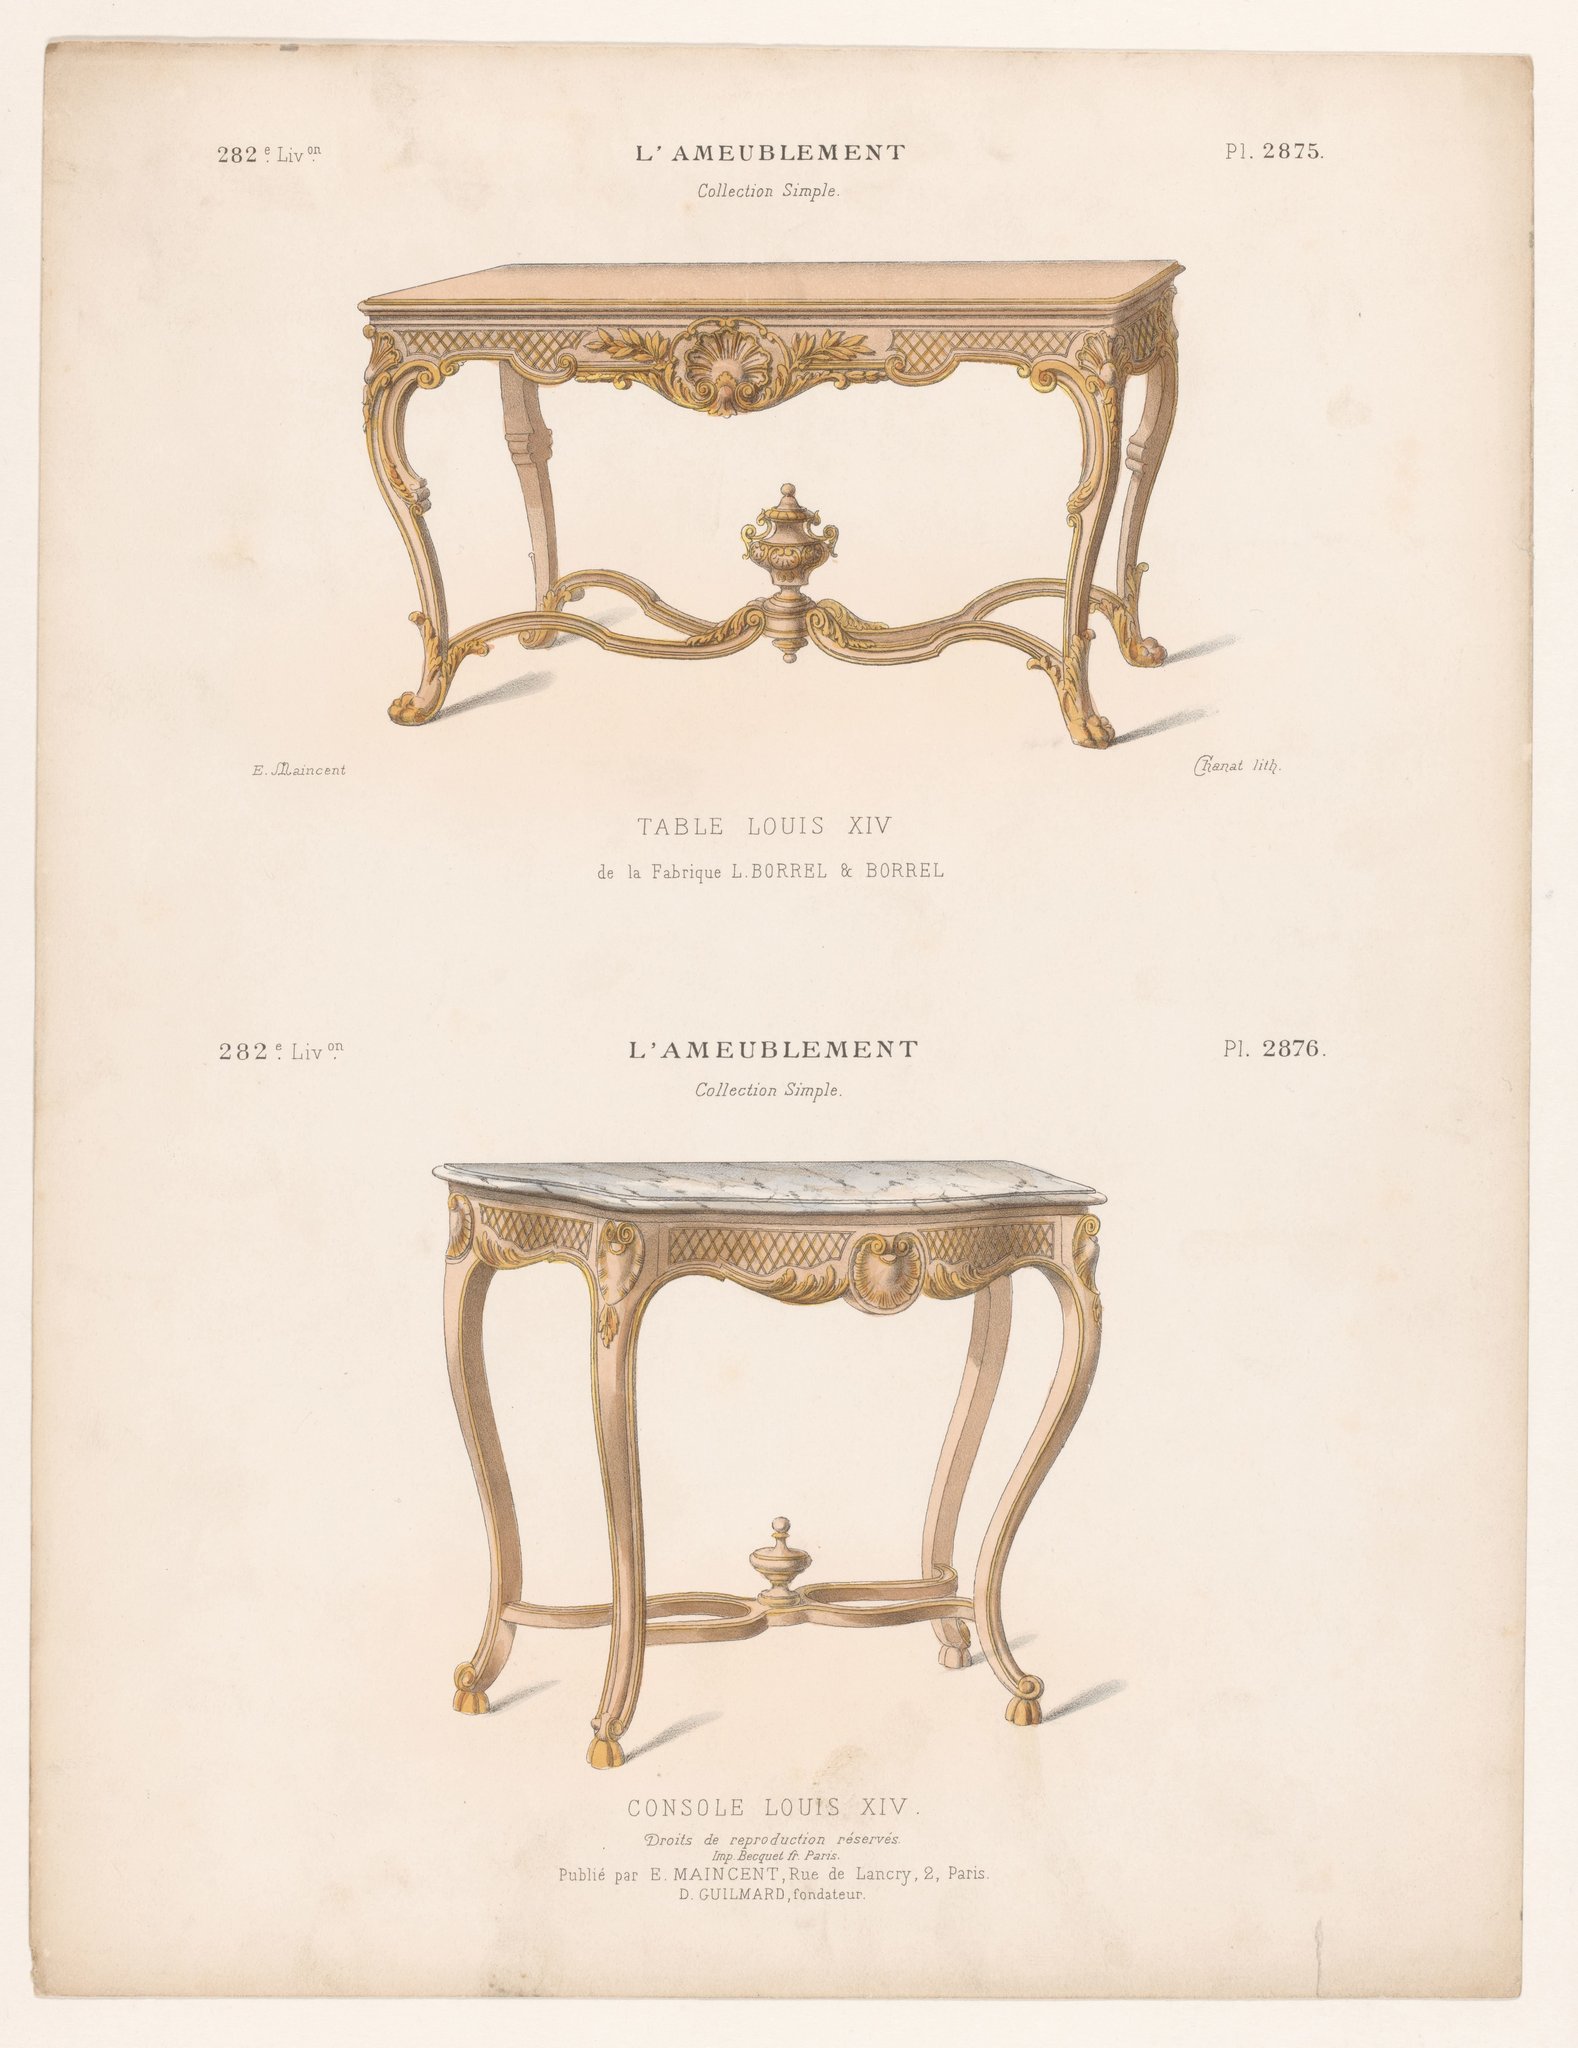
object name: print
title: Table Louis XIV / Console Louis XIV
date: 1885-1895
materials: paper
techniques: hand coloring, lithograph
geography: paris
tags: table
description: Twee tafels in de Lodewijk XIV-stijl. Prent uit 282e Livraison.